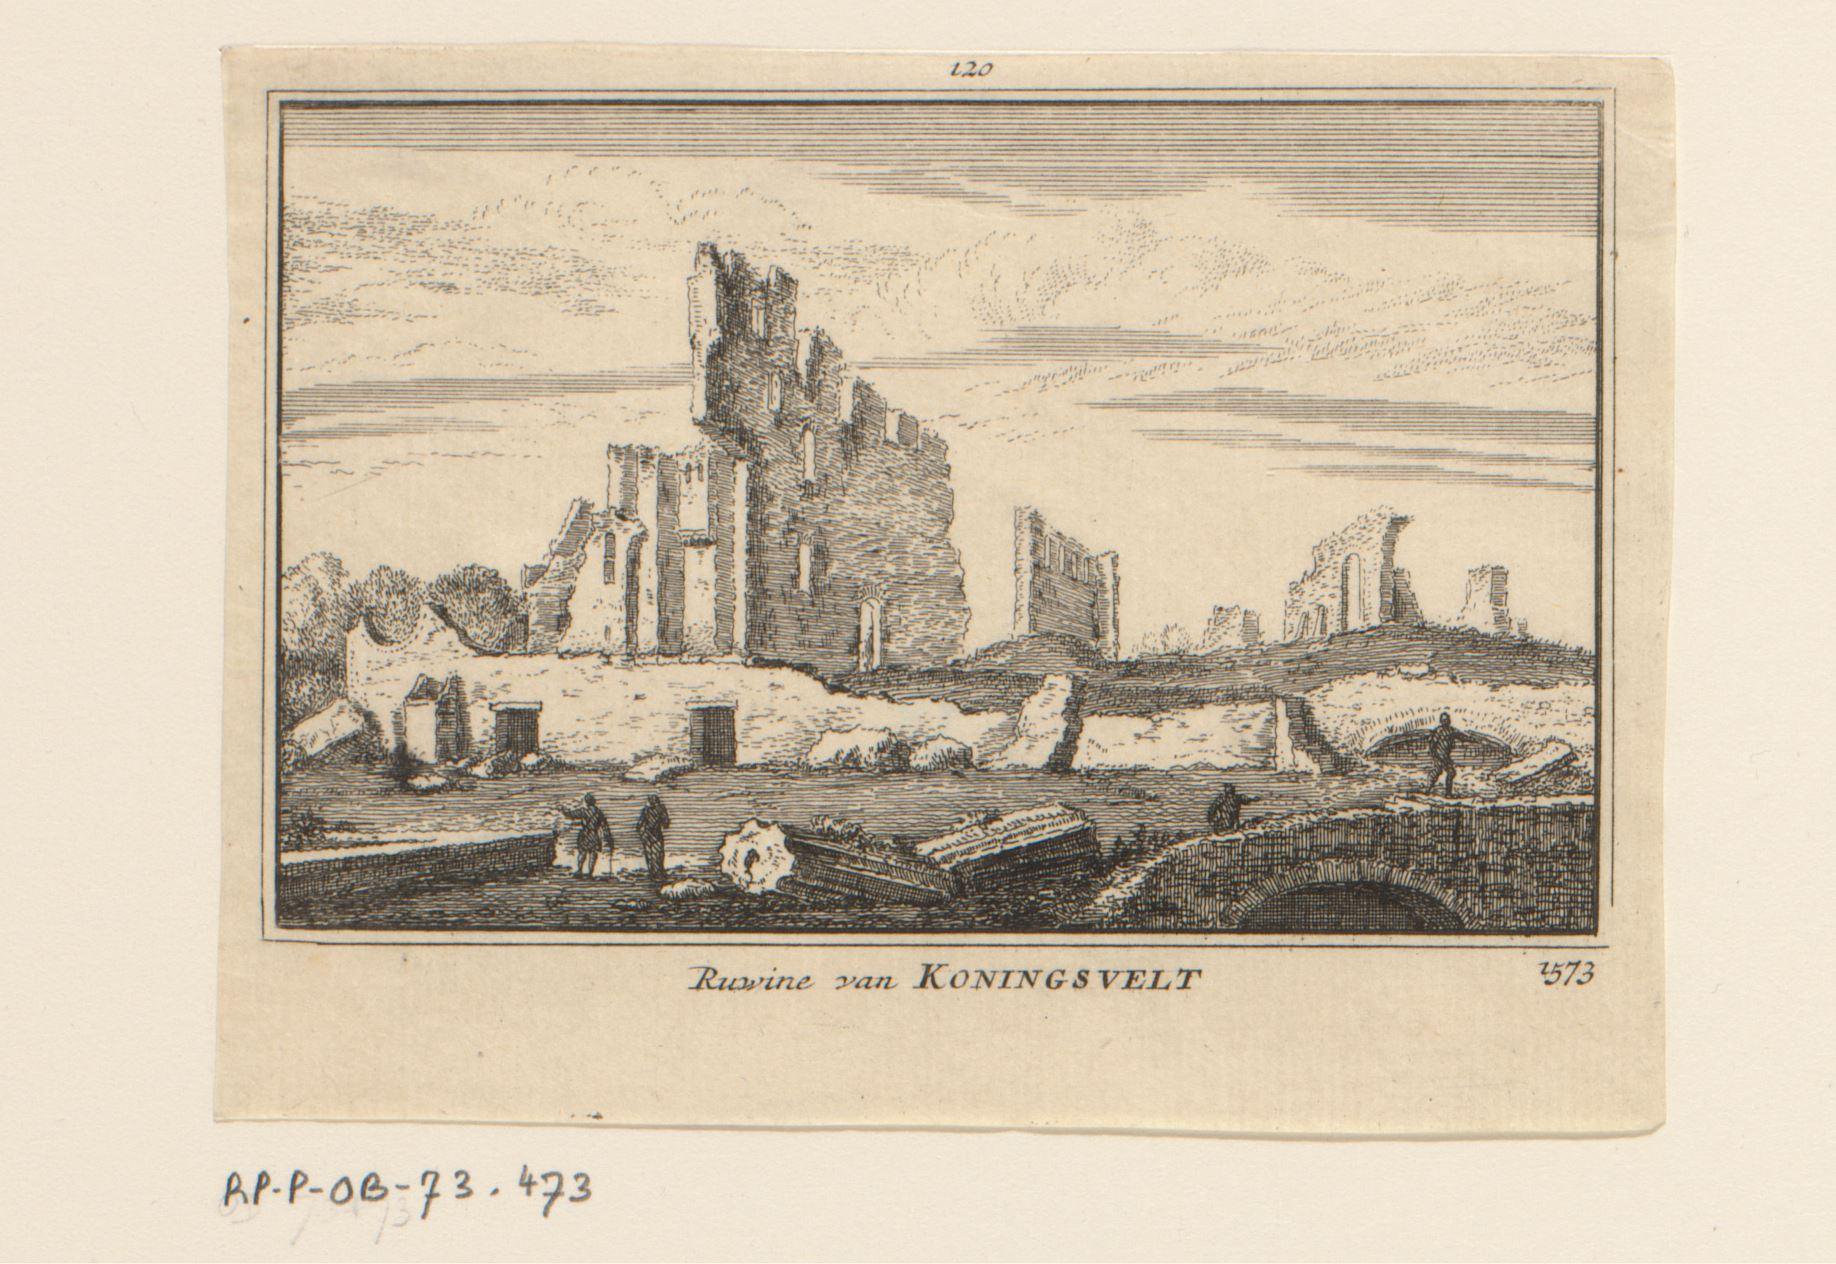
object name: book illustration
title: Ruwine van Koningsvelt 1573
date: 1727-1733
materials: paper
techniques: etching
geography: amsterdam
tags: ruin of church, monastery, etc.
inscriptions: collector's mark: Lugt 2228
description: Illustratie uit: Abraham Rademaker, Matthaeus Brouërius van Niedek, Isaac Le Long, Kabinet van Nederlandsche en Kleefsche outheden en (...) voorname stads- en landgebouwen, Willem Barents en Antoni Schoonenburg: Amsterdam, 1727-1733, ill. nr. 120.